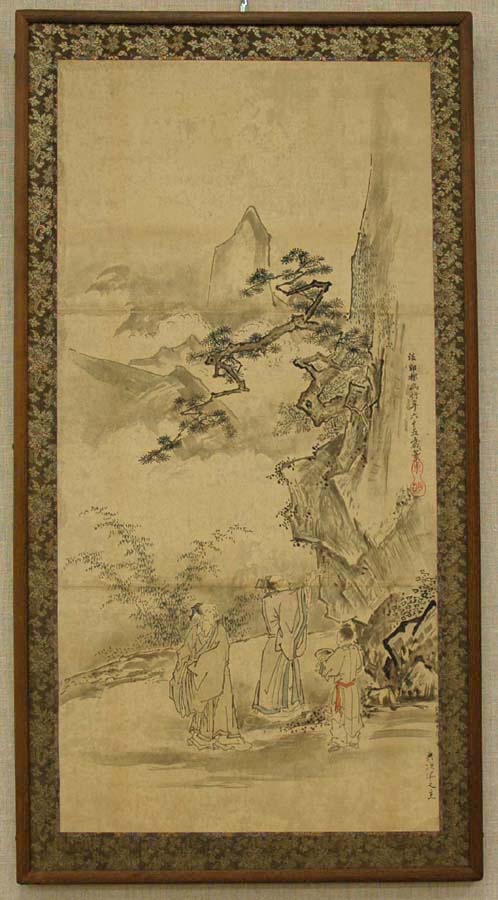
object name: hanging scroll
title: Sketch for a Painting of Mi Fu Inscribing a Poem on a Rock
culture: japanese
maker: kano tan'yū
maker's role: artist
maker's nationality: japanese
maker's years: 1602-1674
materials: ink, panel, paper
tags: men,mountains